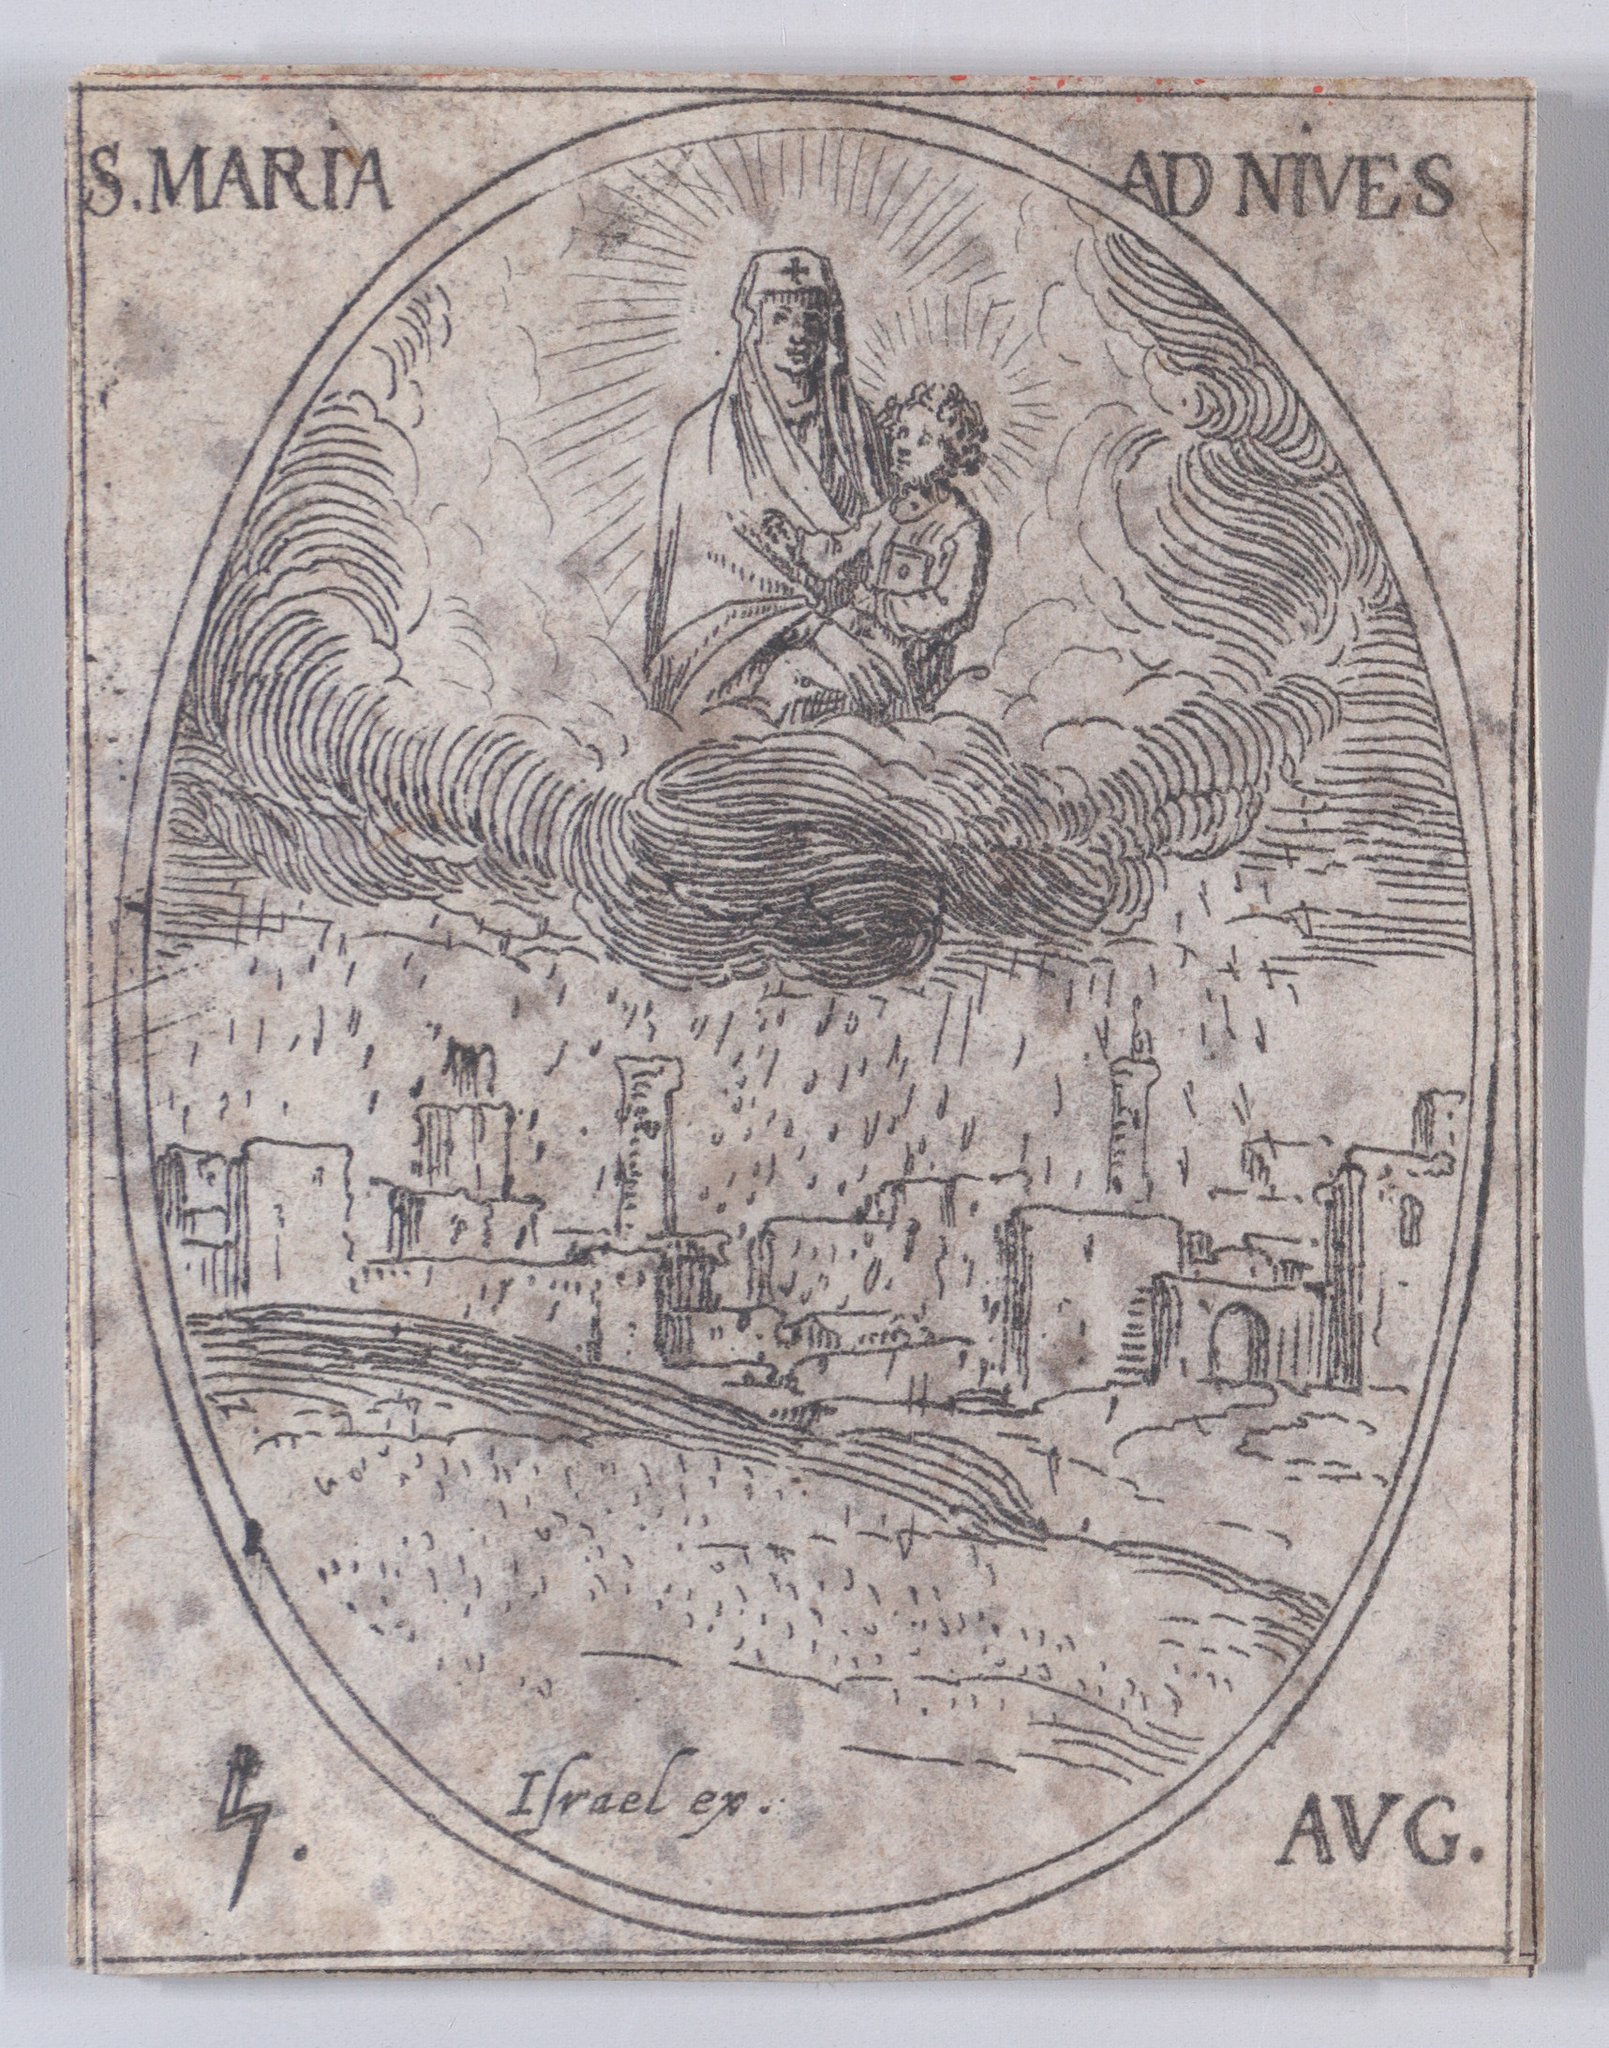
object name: print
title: Ste. Marie des Neiges (Our Lady of the Snow), August 5th, from "Les Images De Tous Les Saincts et Saintes de L'Année" (Images of All of the Saints and Religious Events of the Year)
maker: jacques callot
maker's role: artist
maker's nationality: french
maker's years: 1592-1635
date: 1636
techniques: etching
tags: women,saints